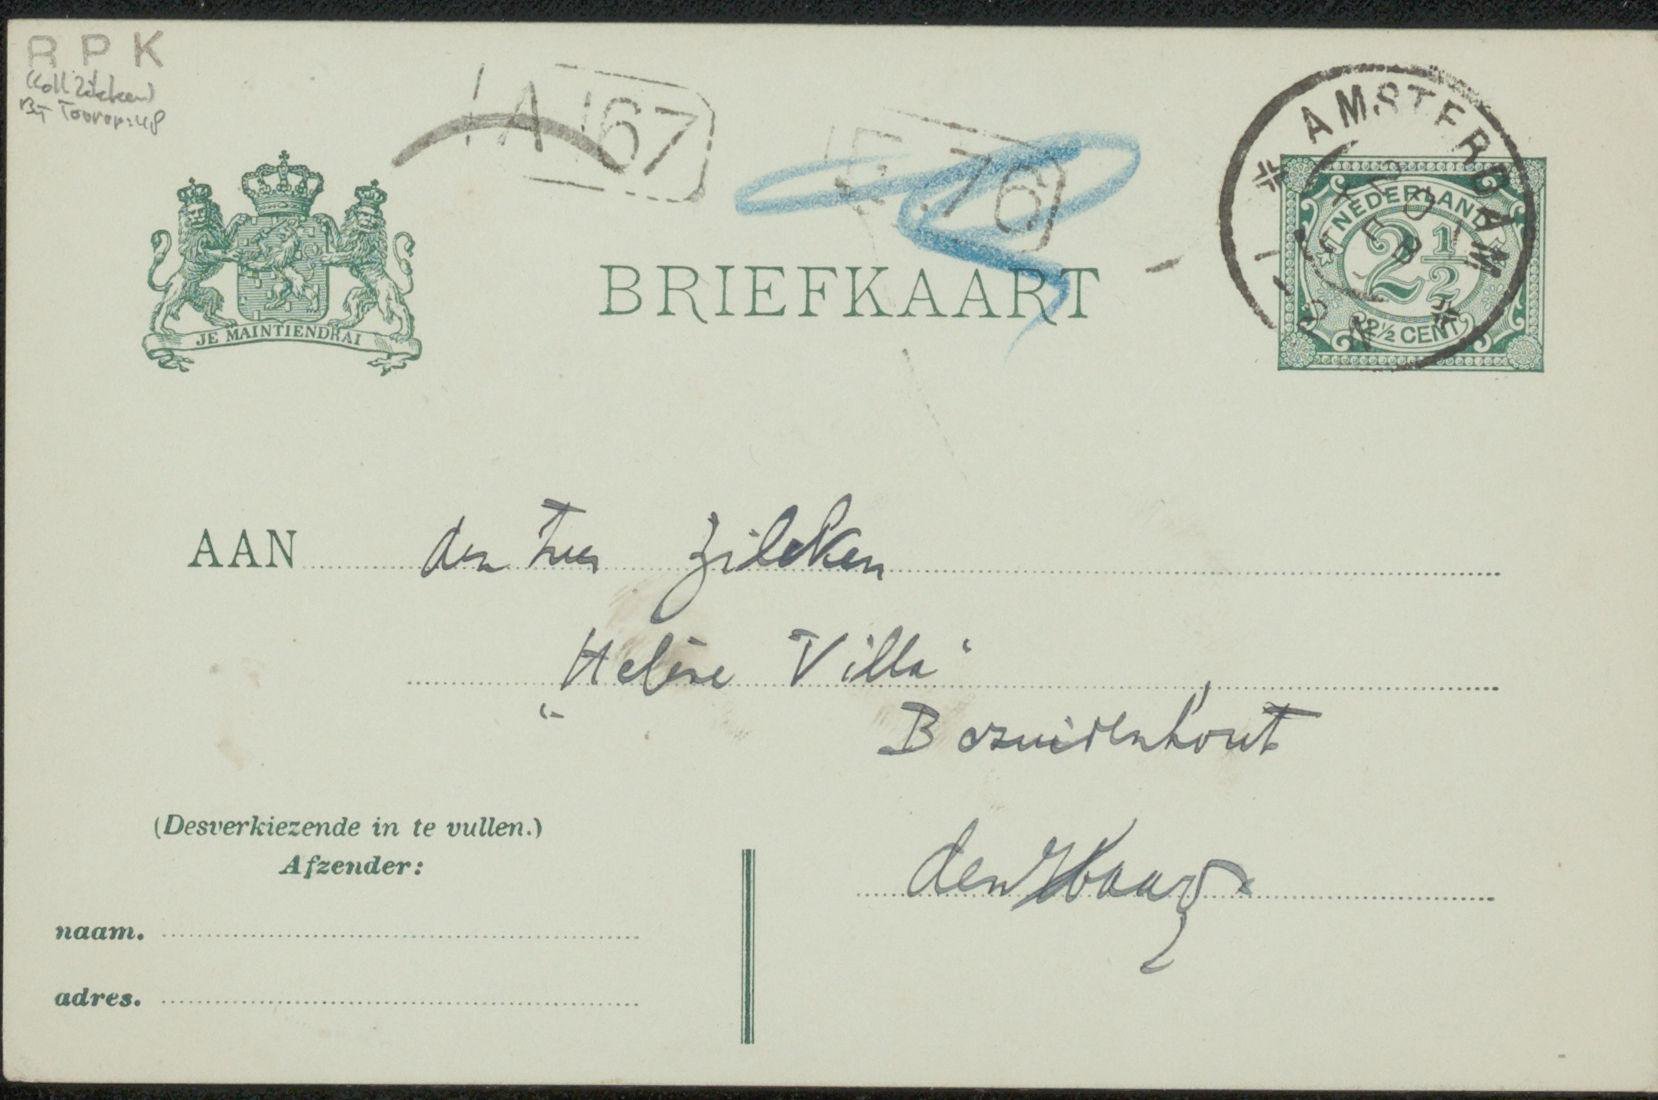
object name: postcard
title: Briefkaart aan Philip Zilcken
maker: jan toorop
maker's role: draughtsman, painter, print maker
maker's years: 1858-1928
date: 1905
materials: cardboard, ink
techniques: pen, writing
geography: amsterdam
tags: camille lemonnier, the hague, draughtsman, philip zilcken, the graphic arts, painting (including book-illumination, miniature-painting), diseases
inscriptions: collector's mark: ‘RPK’